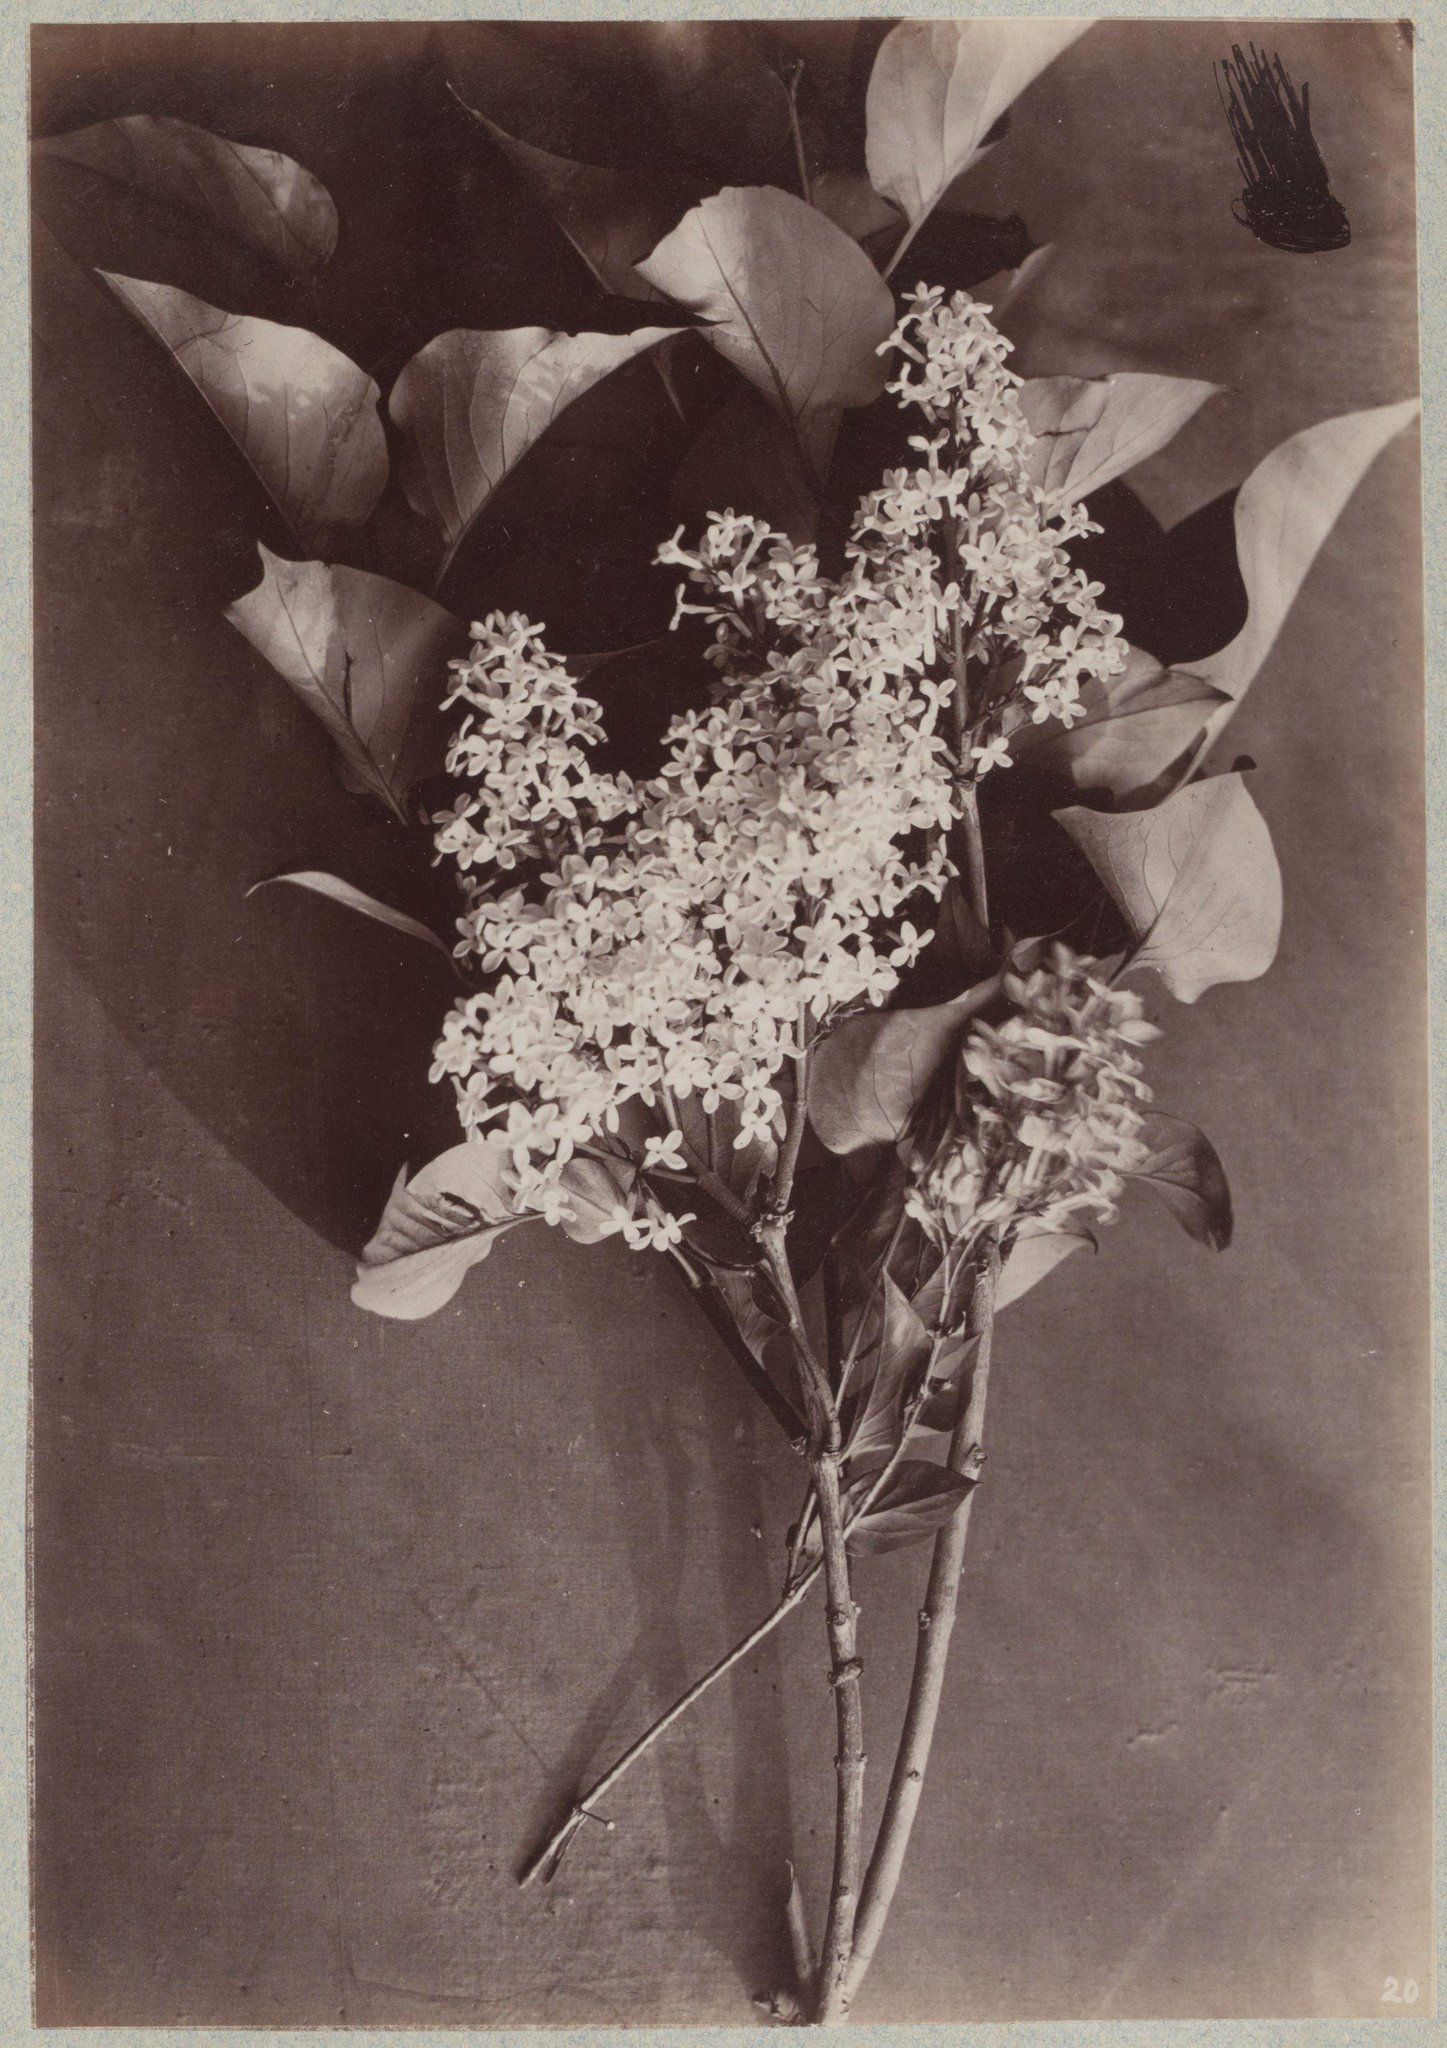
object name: photograph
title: Studies of Plants and Grasses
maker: a. calavas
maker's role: publisher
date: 1885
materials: cardboard, photographic support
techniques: albumen print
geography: paris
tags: flowers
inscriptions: number: ‘20’, collector's mark: Lugt 3937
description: Because photographs were largely considered to be mere aids in the 19th century, the name of the photographer was generally not mentioned. The name on the mounts of these photographs is that of the publisher, the Paris firm of Calavas. From around 1875 it published vast amounts of photographs that were widely used as study material by artists.